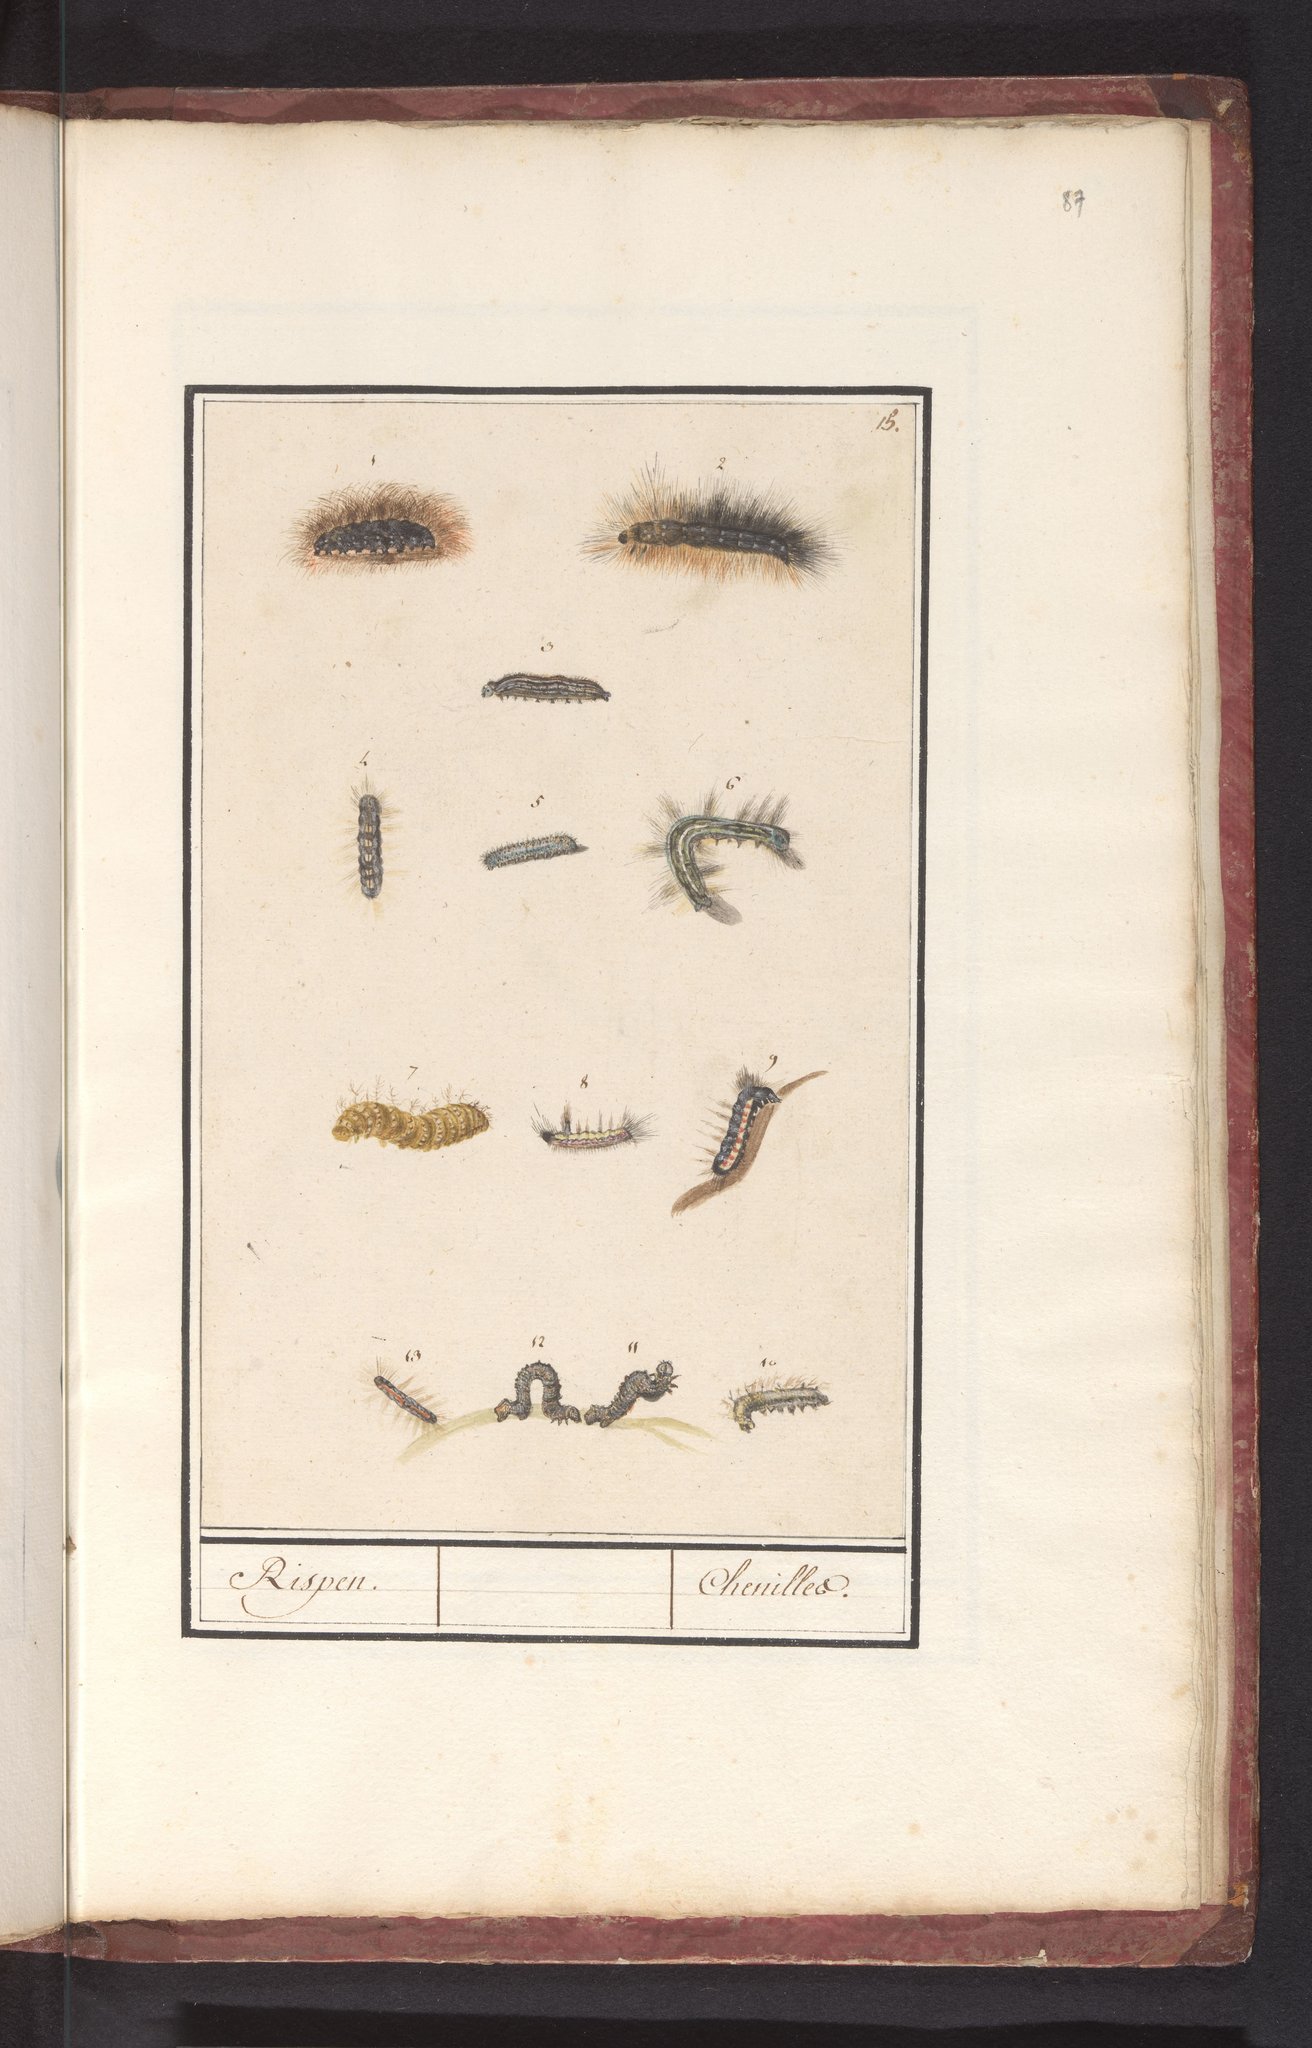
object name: drawing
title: Rupsen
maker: anselmus boëtius de boodt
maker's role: draughtsman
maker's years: 1550-1632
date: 1596-1610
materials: chalk, paint, ink, paper, pencil, watercolor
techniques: brush, pen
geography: prague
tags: insects: caterpillar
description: Blad met dertien behaarde rupsen, genummerd 1-13. Genummerd rechtsboven: 15. Onderdeel van het zesde album met tekeningen van vissen, schelpen en insekten. Zesde van twaalf albums met tekeningen van dieren, vogels en planten bekend rond 1600, gemaakt in opdracht van keizer Rudolf II. Met toelichting in Nederlands, Latijn en Frans.